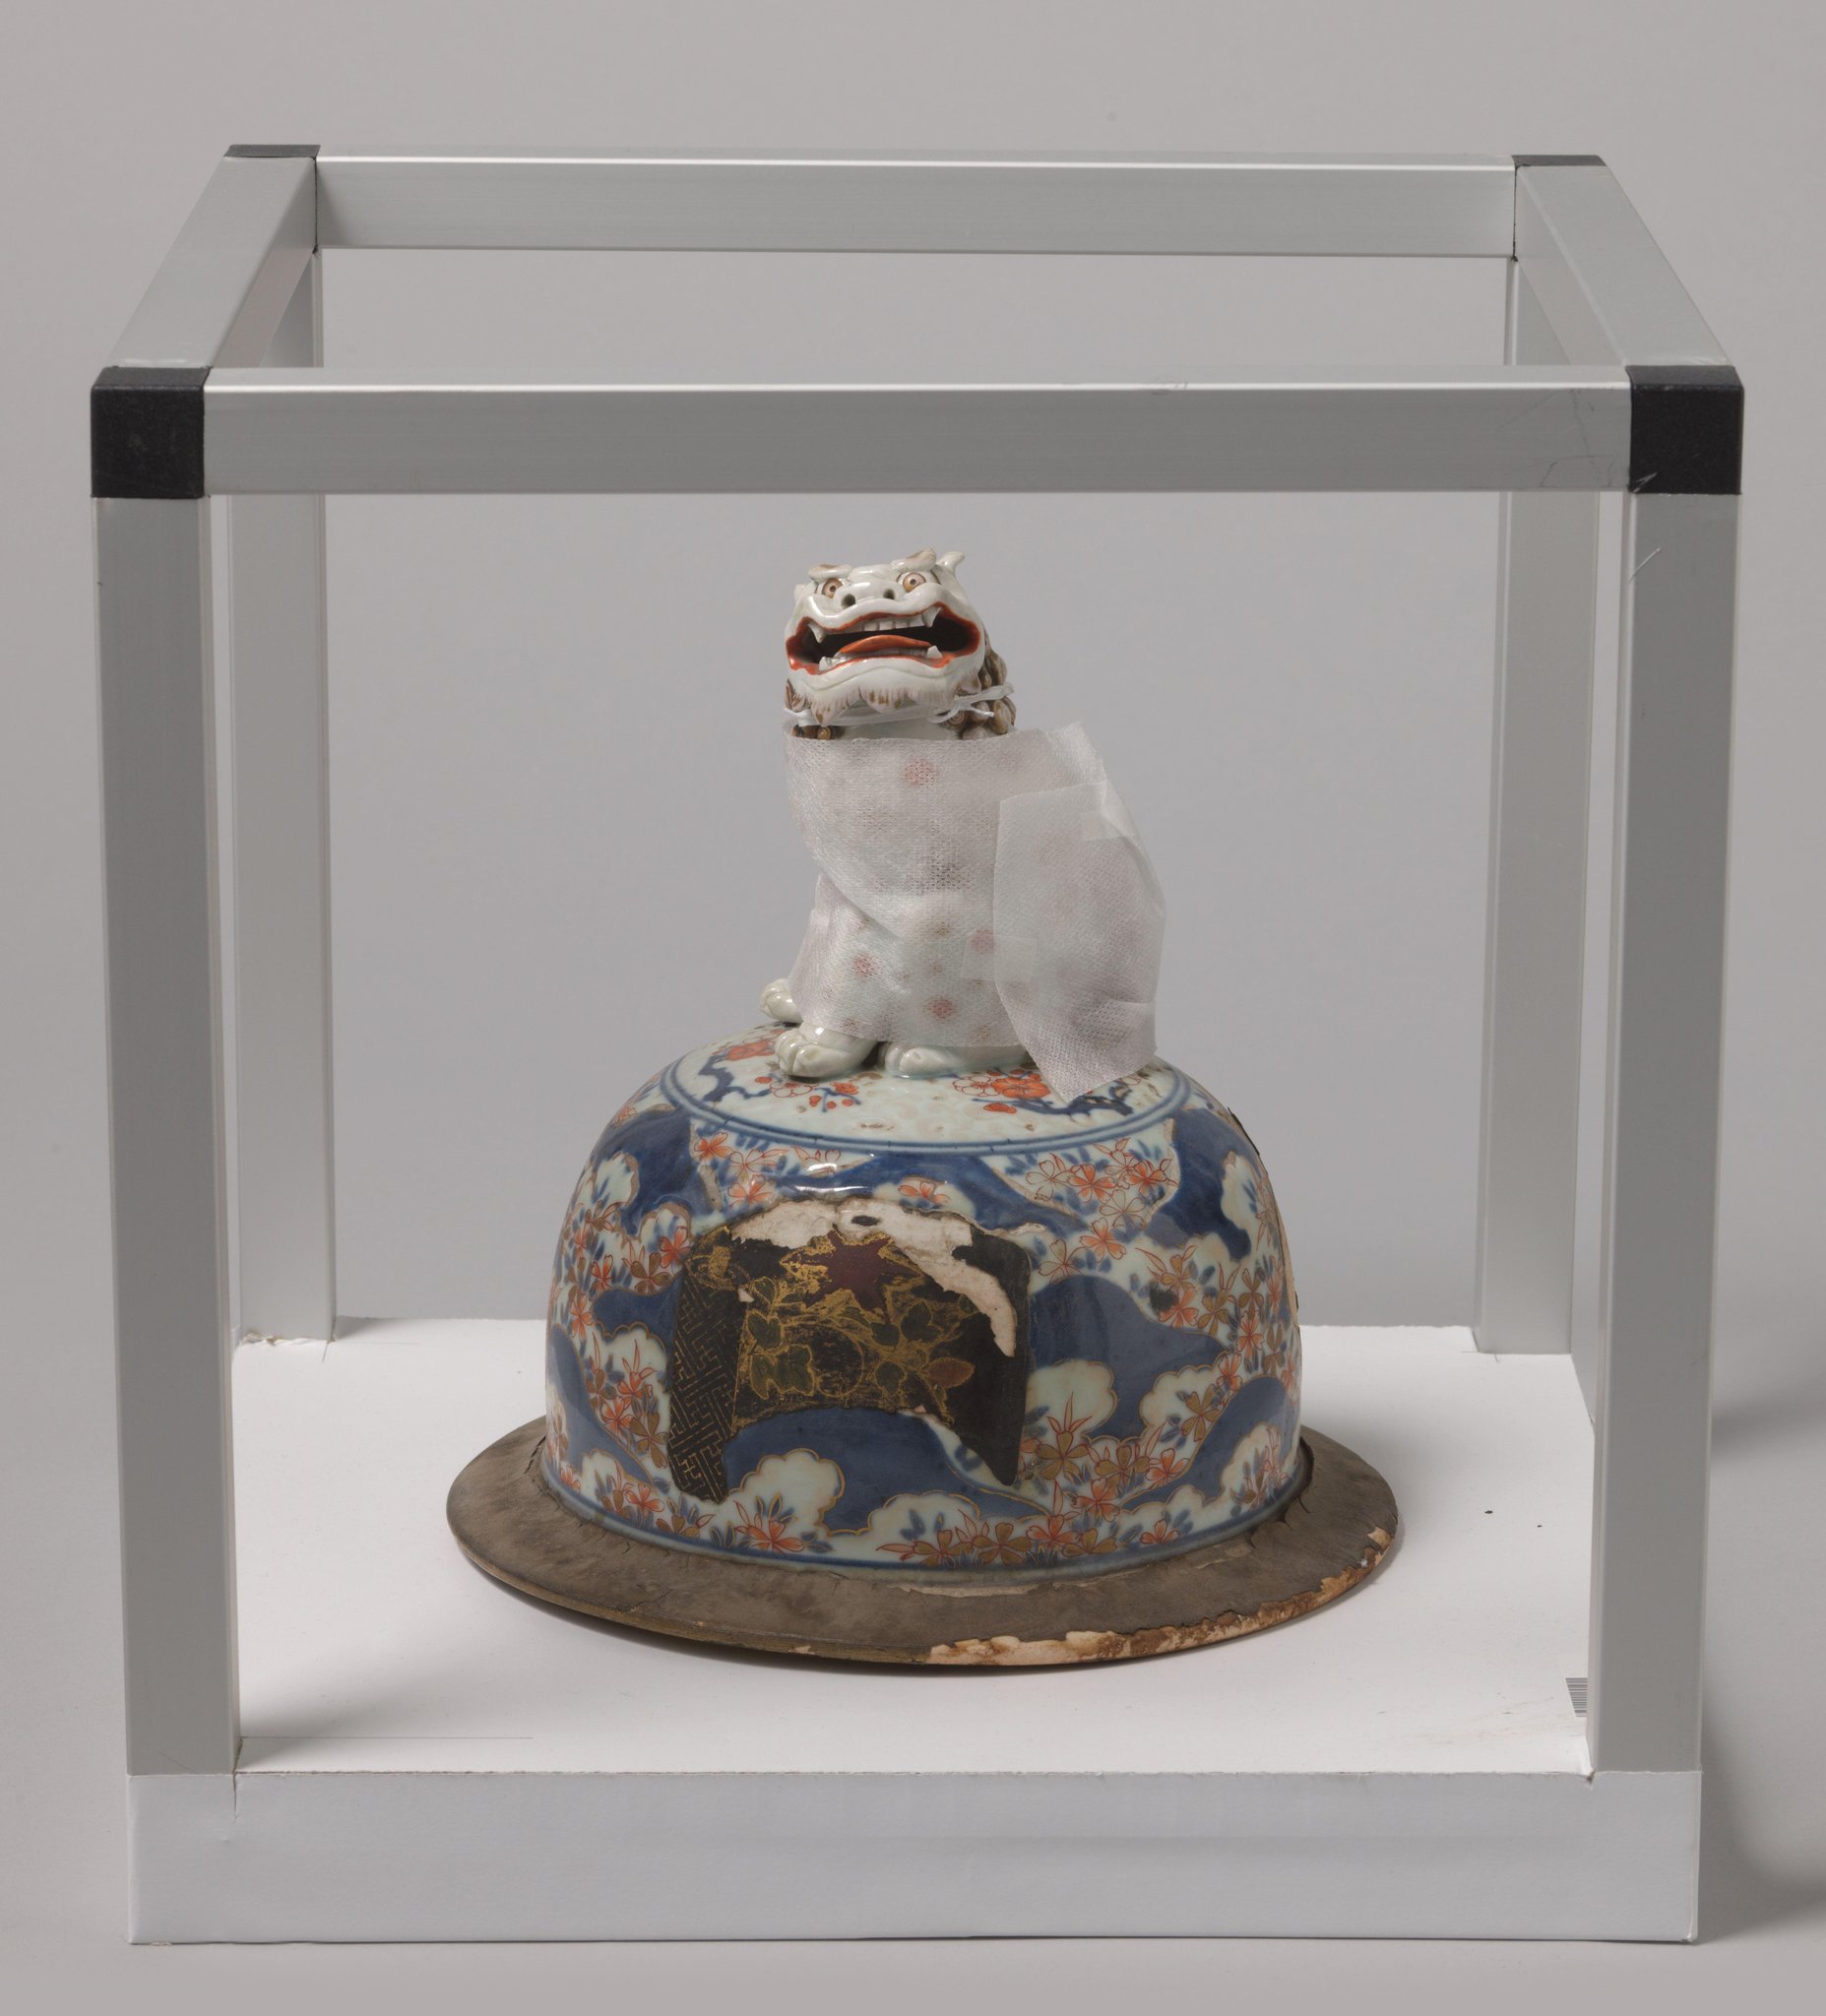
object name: lid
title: Deksel van dekselvaas met Imari-decoratie en lakwerk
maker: Anonymous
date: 1700-1725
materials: glaze, lacquer, paint, porcelain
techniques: firing, gilding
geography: japan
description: Een bol deksel met recht uitstekende dekselrand en bekroond met een leeuw.